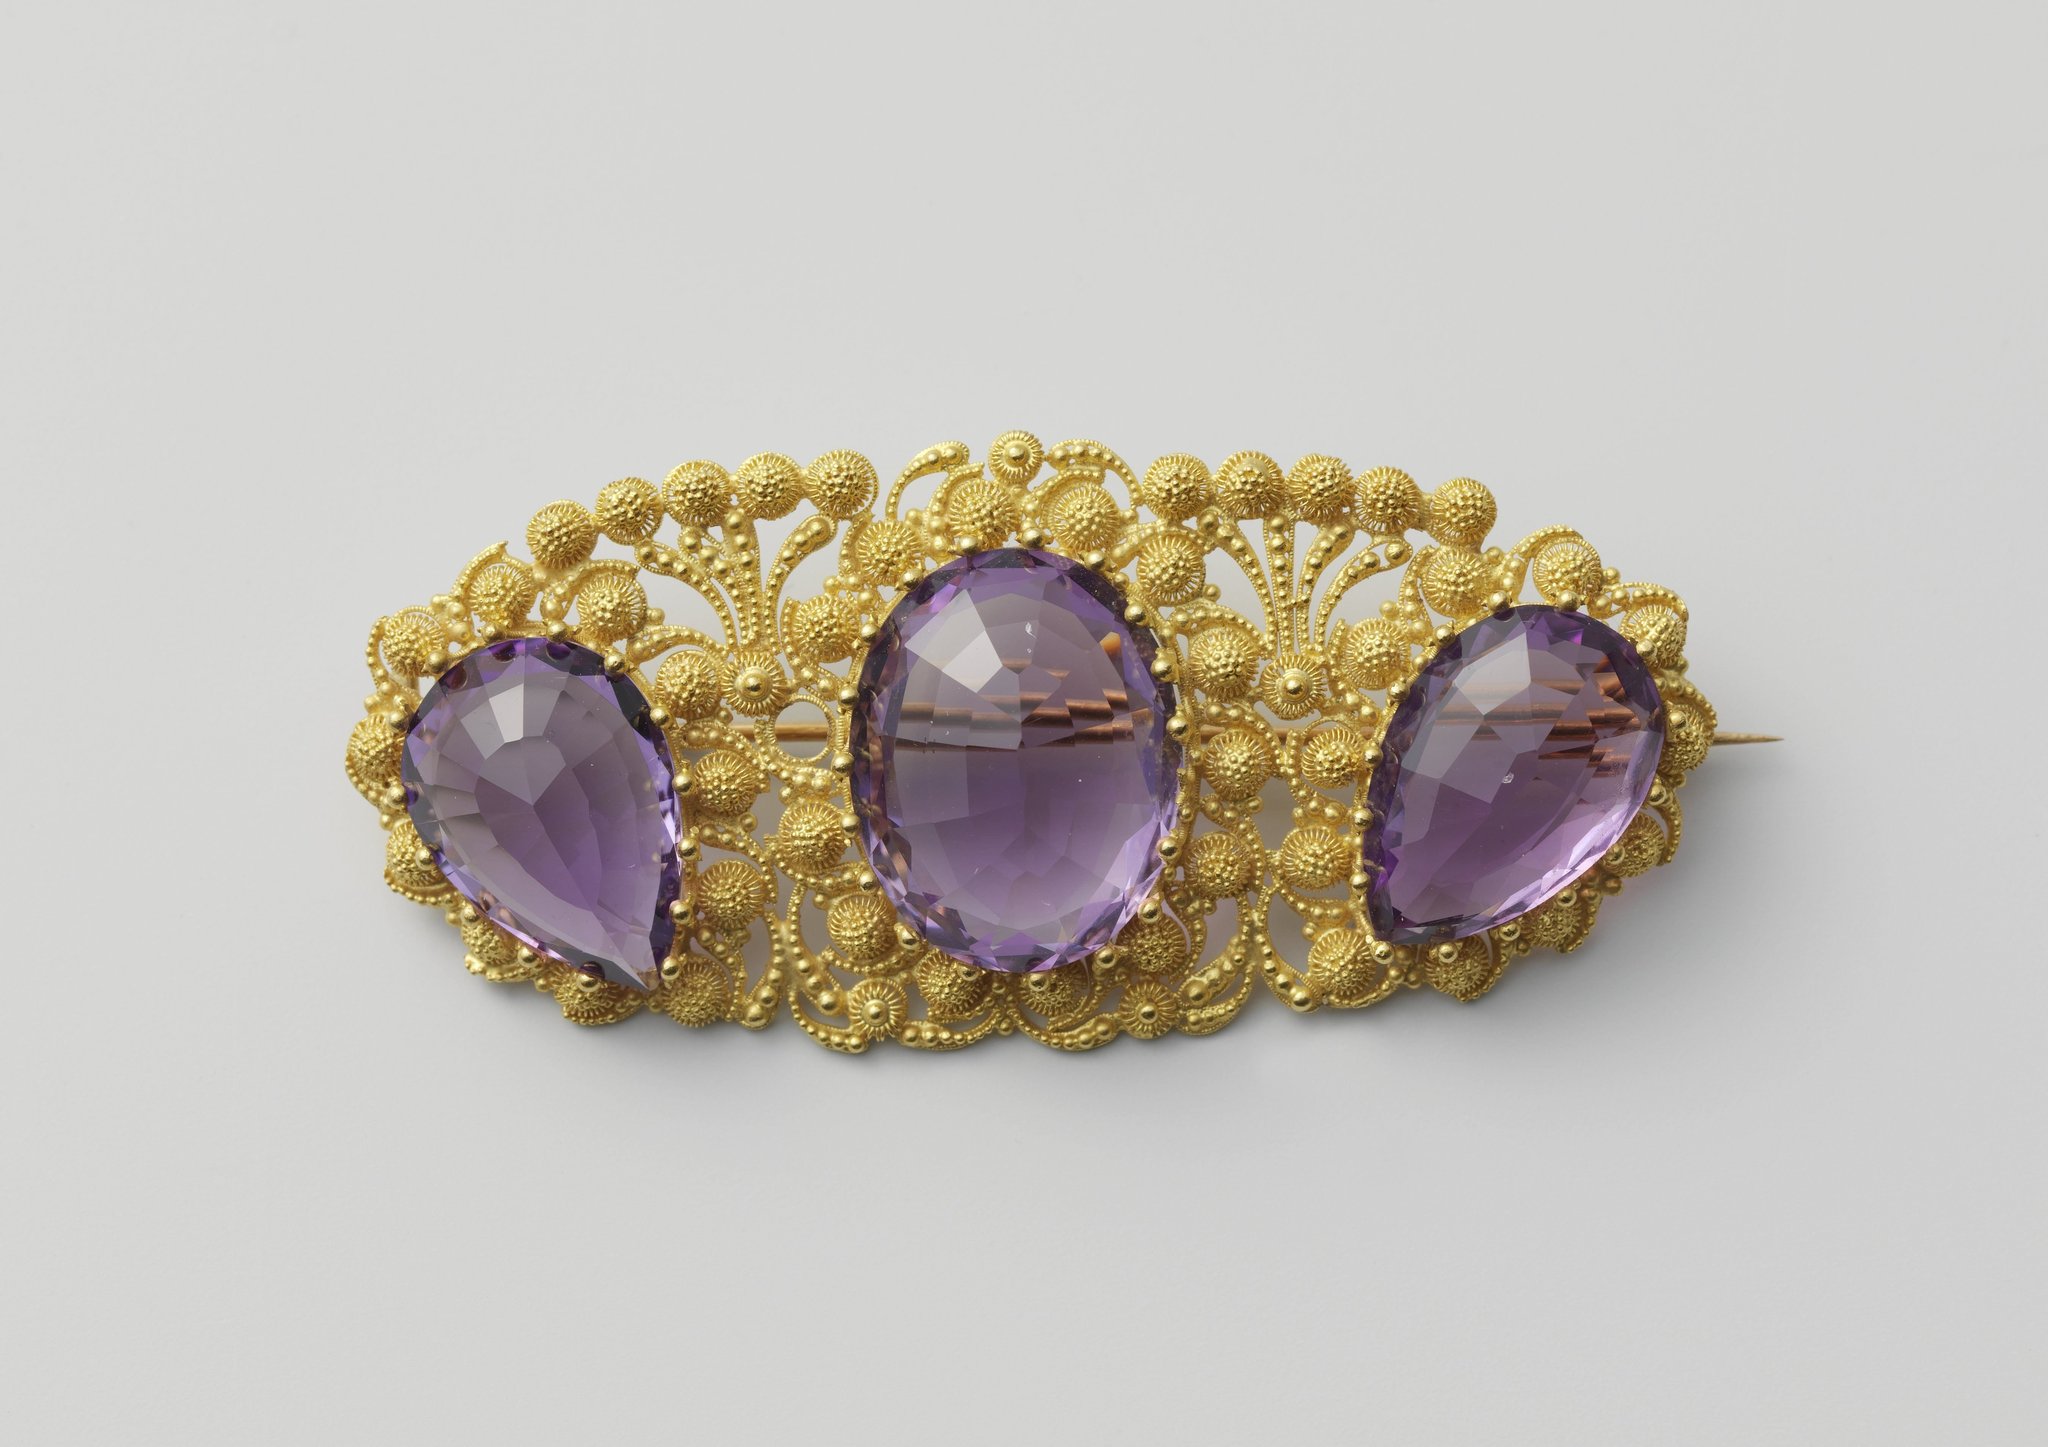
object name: jewellery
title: Broche van goud en amethist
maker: jean baptiste bonnard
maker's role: goldsmith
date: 1824-1829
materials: gemstone, gold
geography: amsterdam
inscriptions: alloy mark: ‘leeuwenkop naar links (Nederland, 1813-1906)’